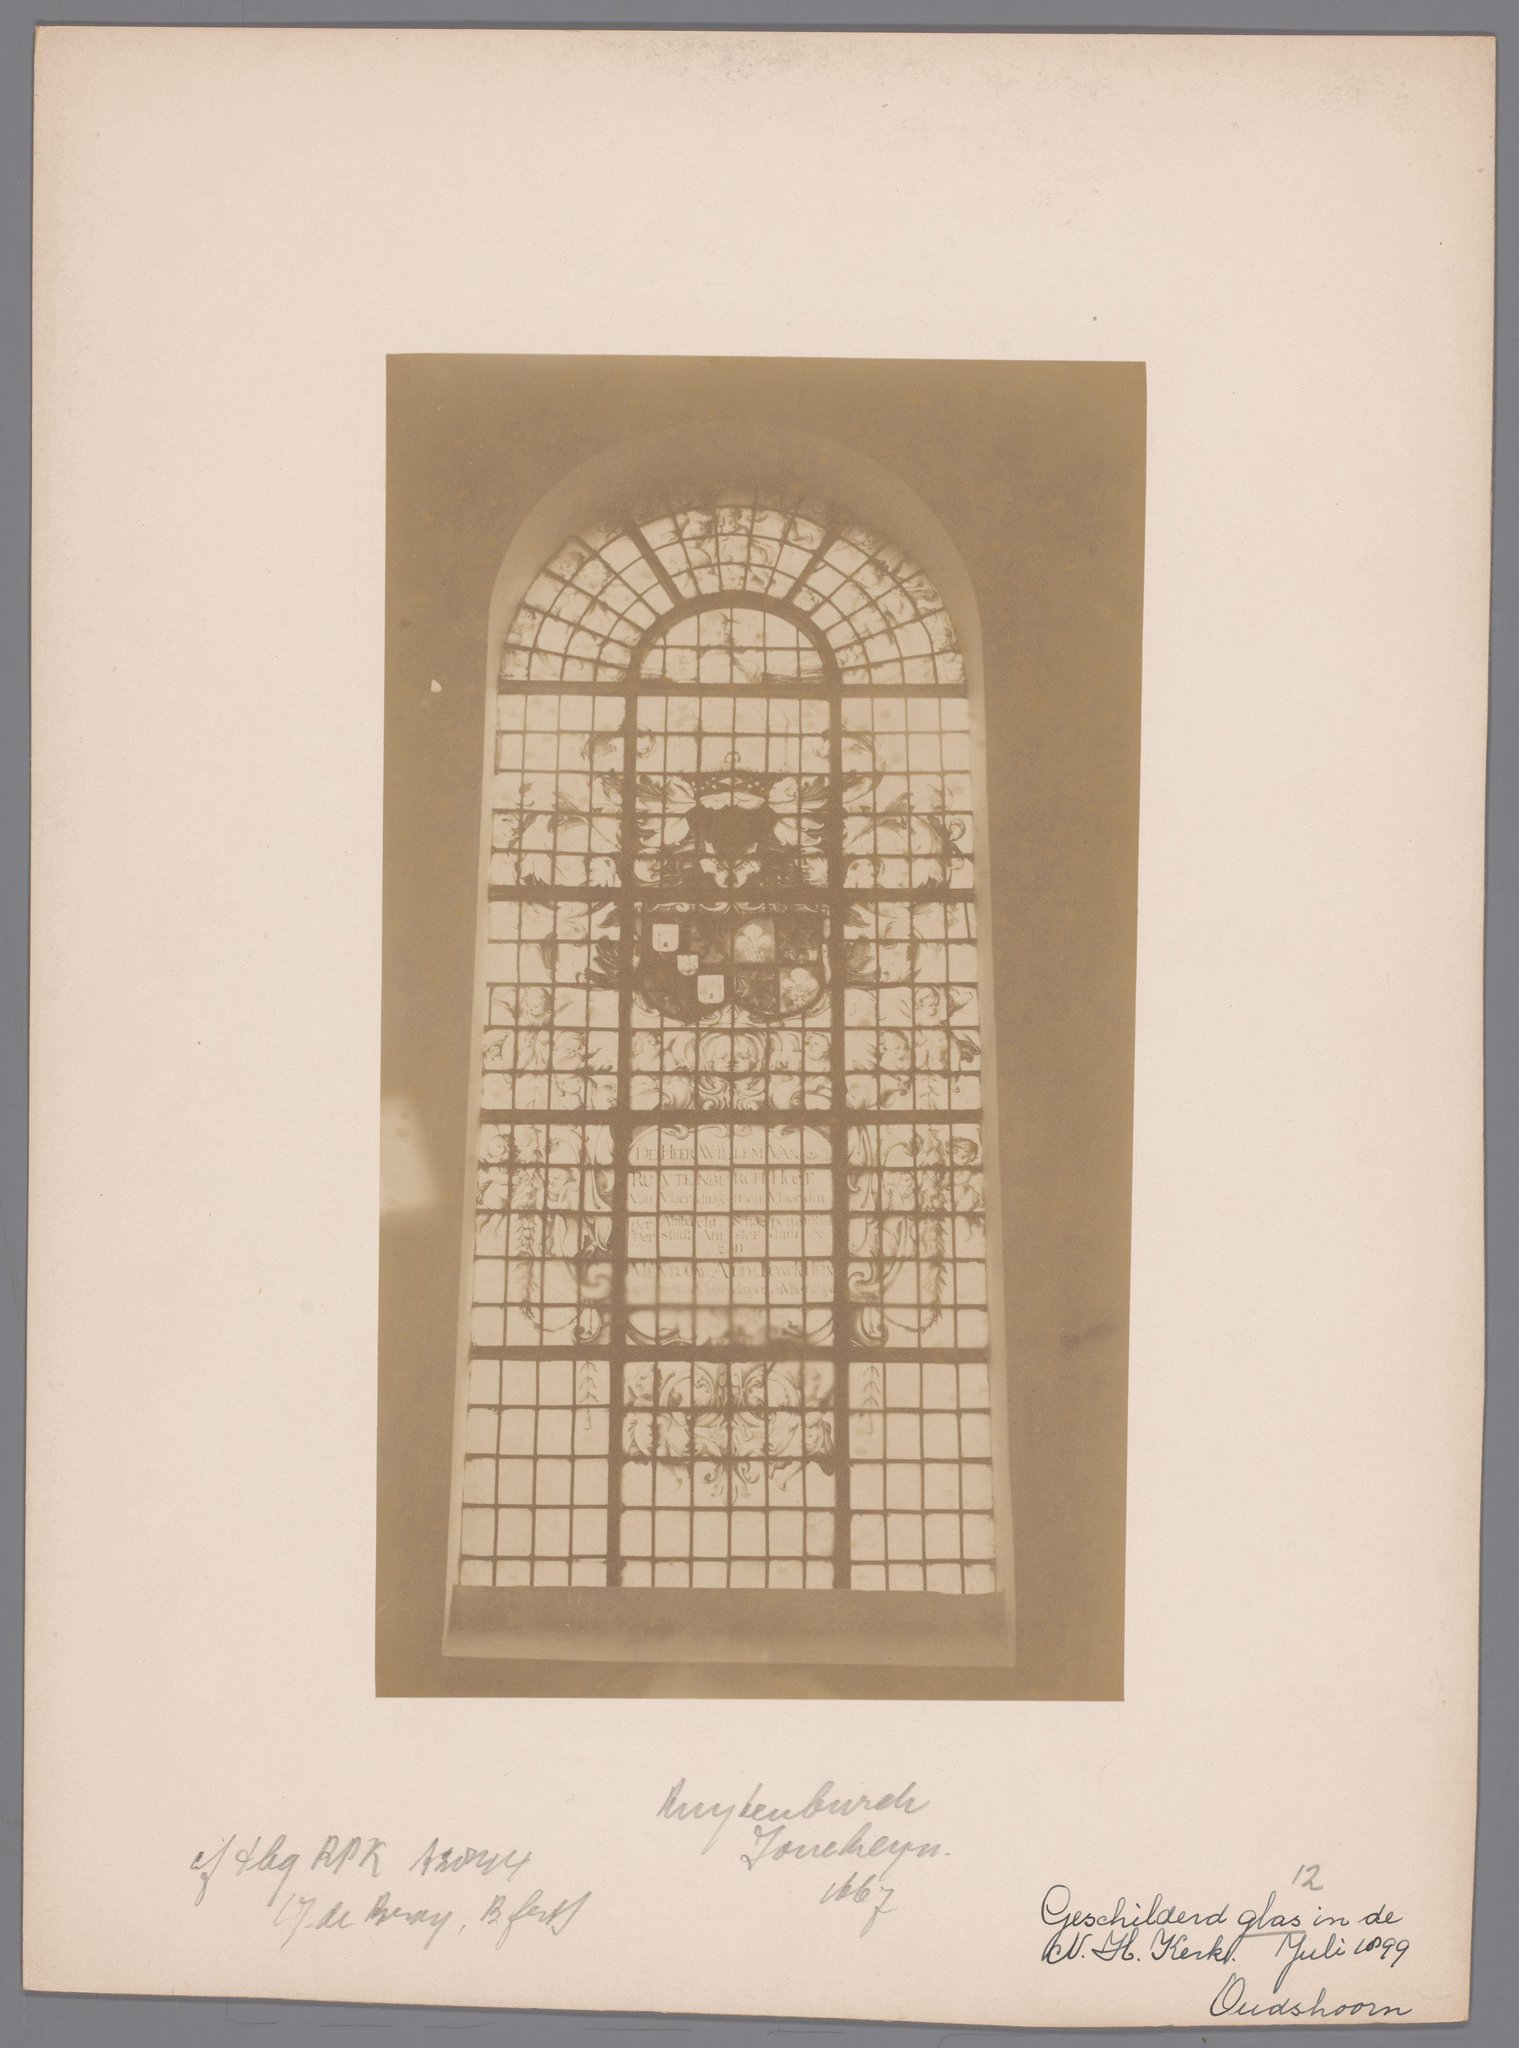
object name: photograph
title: Geschilderd raam in de Oudshoornse Kerk te Oudshoorn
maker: anoniem (monumentenzorg)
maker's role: fotograaf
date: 1899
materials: cardboard, photographic support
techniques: albumen print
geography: oudshoorn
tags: church-window, e.g. rose-window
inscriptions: annotation: ‘Geschilderd glas in de Ned Herv kerk te Oudshoorn/ Juli 1899’, annotation: ‘Geschilderd glas 12 in de N.H. Kerk Juli 1899/ Oudshoorn’, annotation: ‘[...] RPK A2844 [...]’